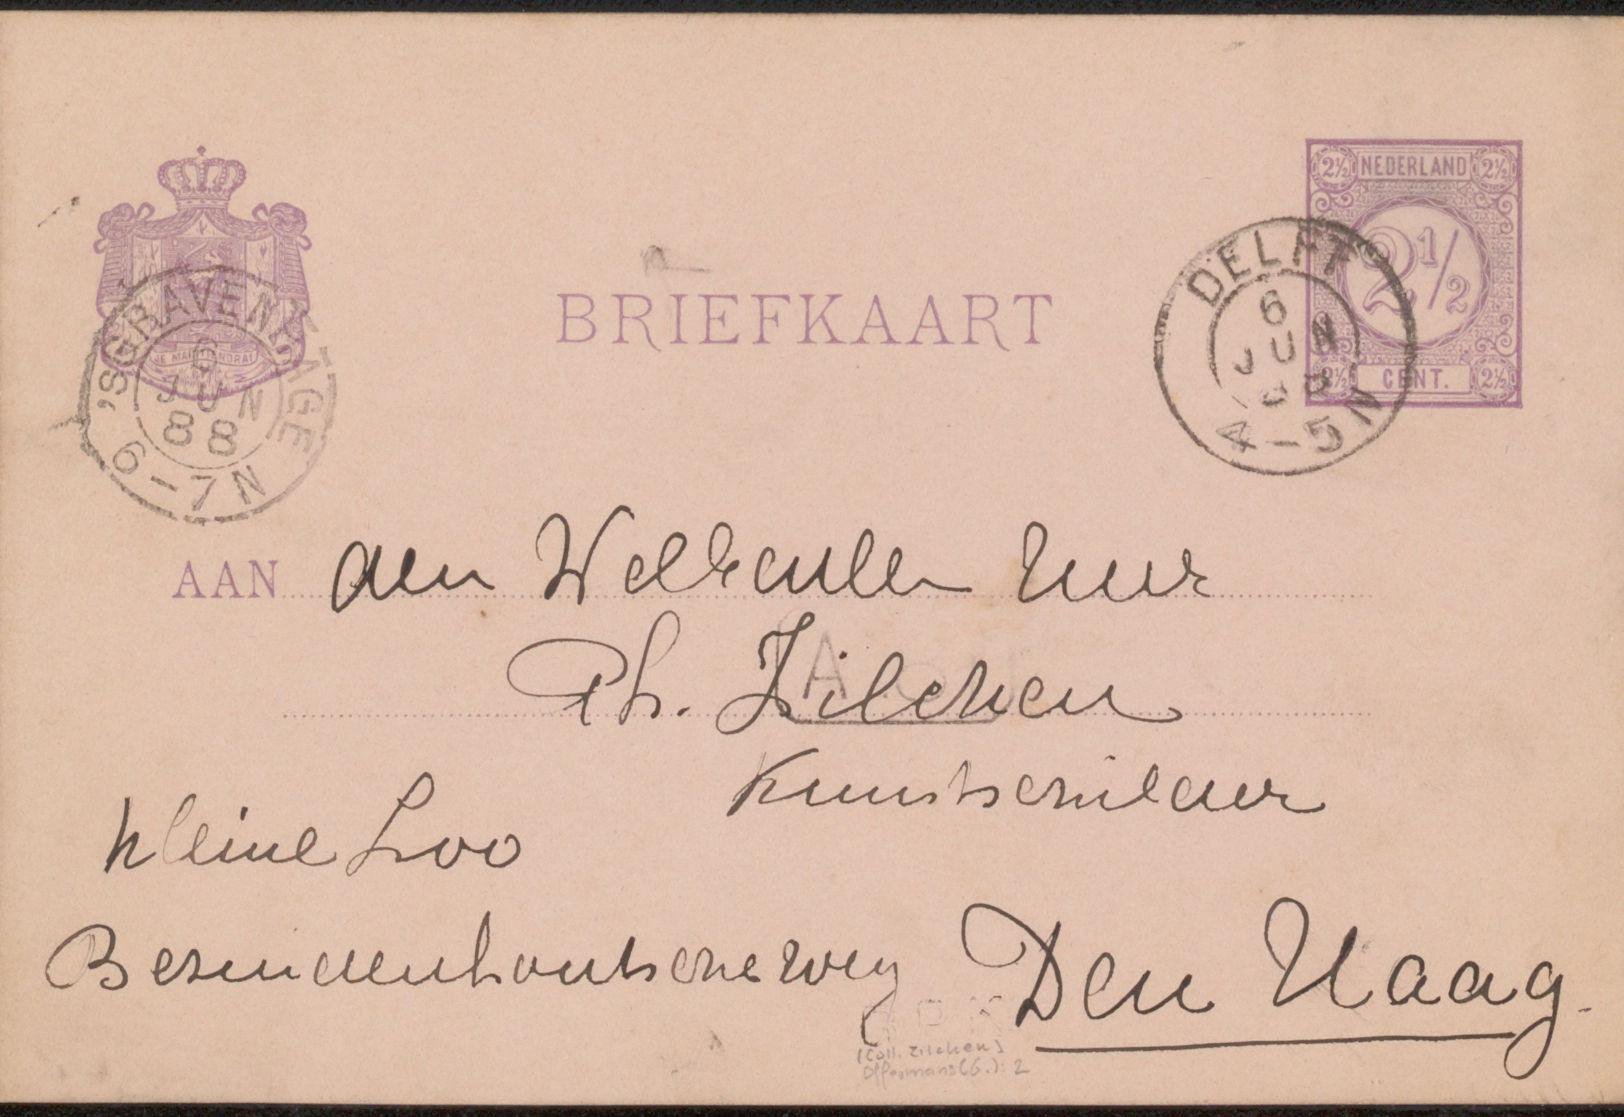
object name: postcard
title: Briefkaart aan Philip Zilcken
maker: g.j.d. offermans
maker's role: ceramicist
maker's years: 1857-1914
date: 1888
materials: cardboard, ink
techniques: pen, writing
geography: delft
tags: the hague, painter, draughtsman, philip zilcken, the arts of the stage: ballet, theatre, musical drama, motion picture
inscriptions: collector's mark: ‘RPK’